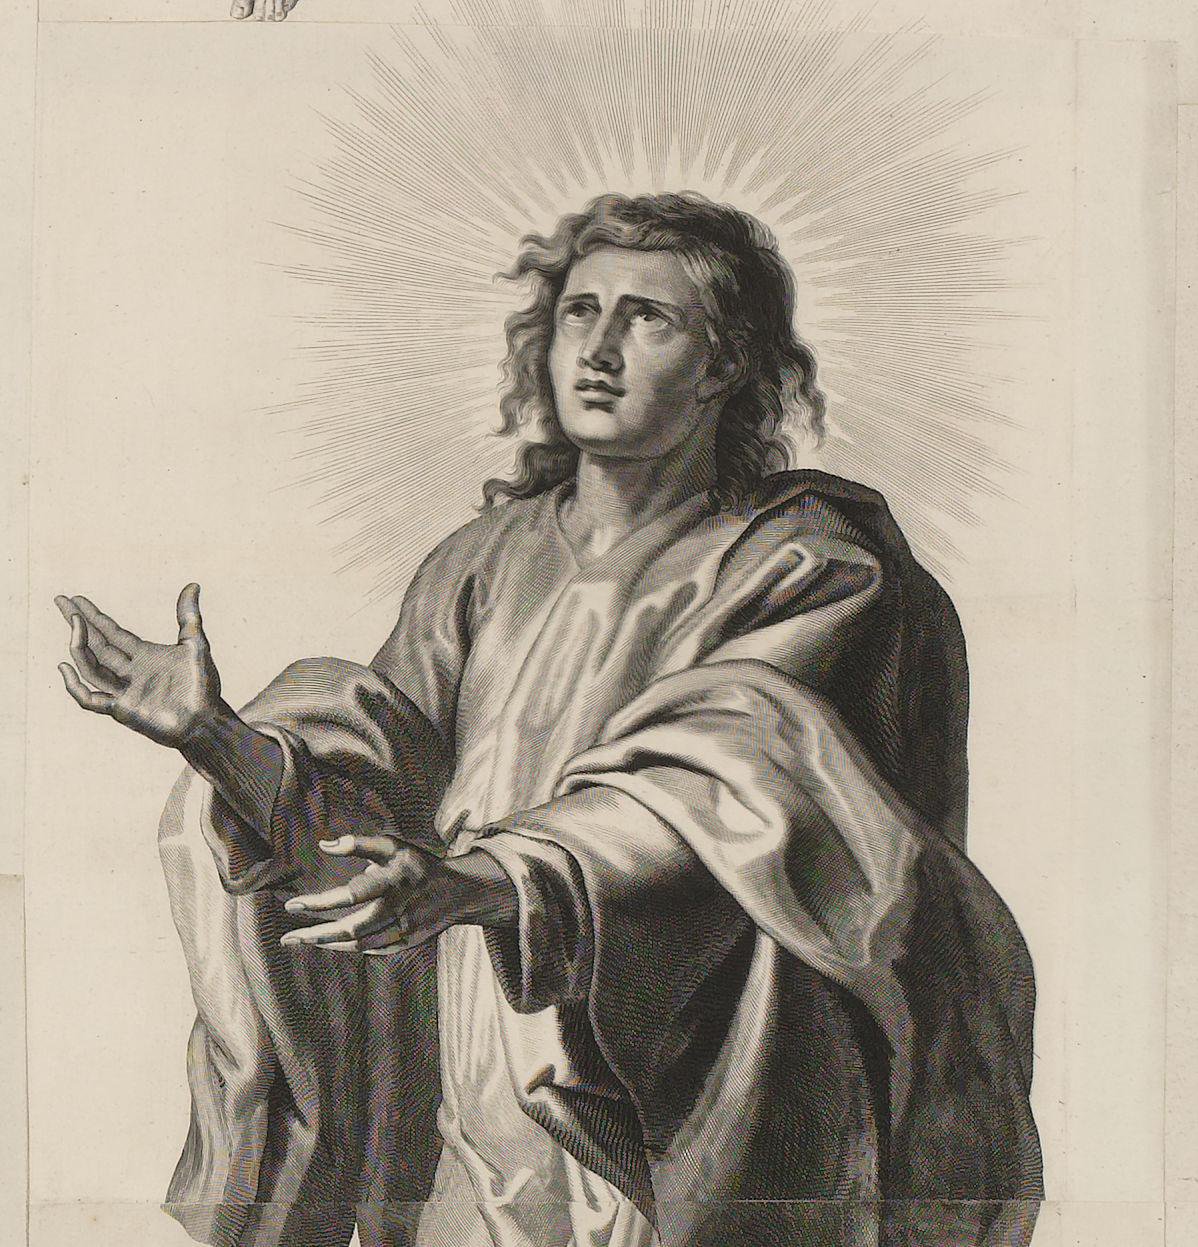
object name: print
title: Gekruisigde Christus met Maria, Johannes en Maria Magdelena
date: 1650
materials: paper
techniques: engraving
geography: antwerp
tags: crucified christ with mary, john, and mary magdalene, cupids: 'amores', 'amoretti', 'putti'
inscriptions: collector's mark: Lugt 1838, collector's mark: Lugt 240